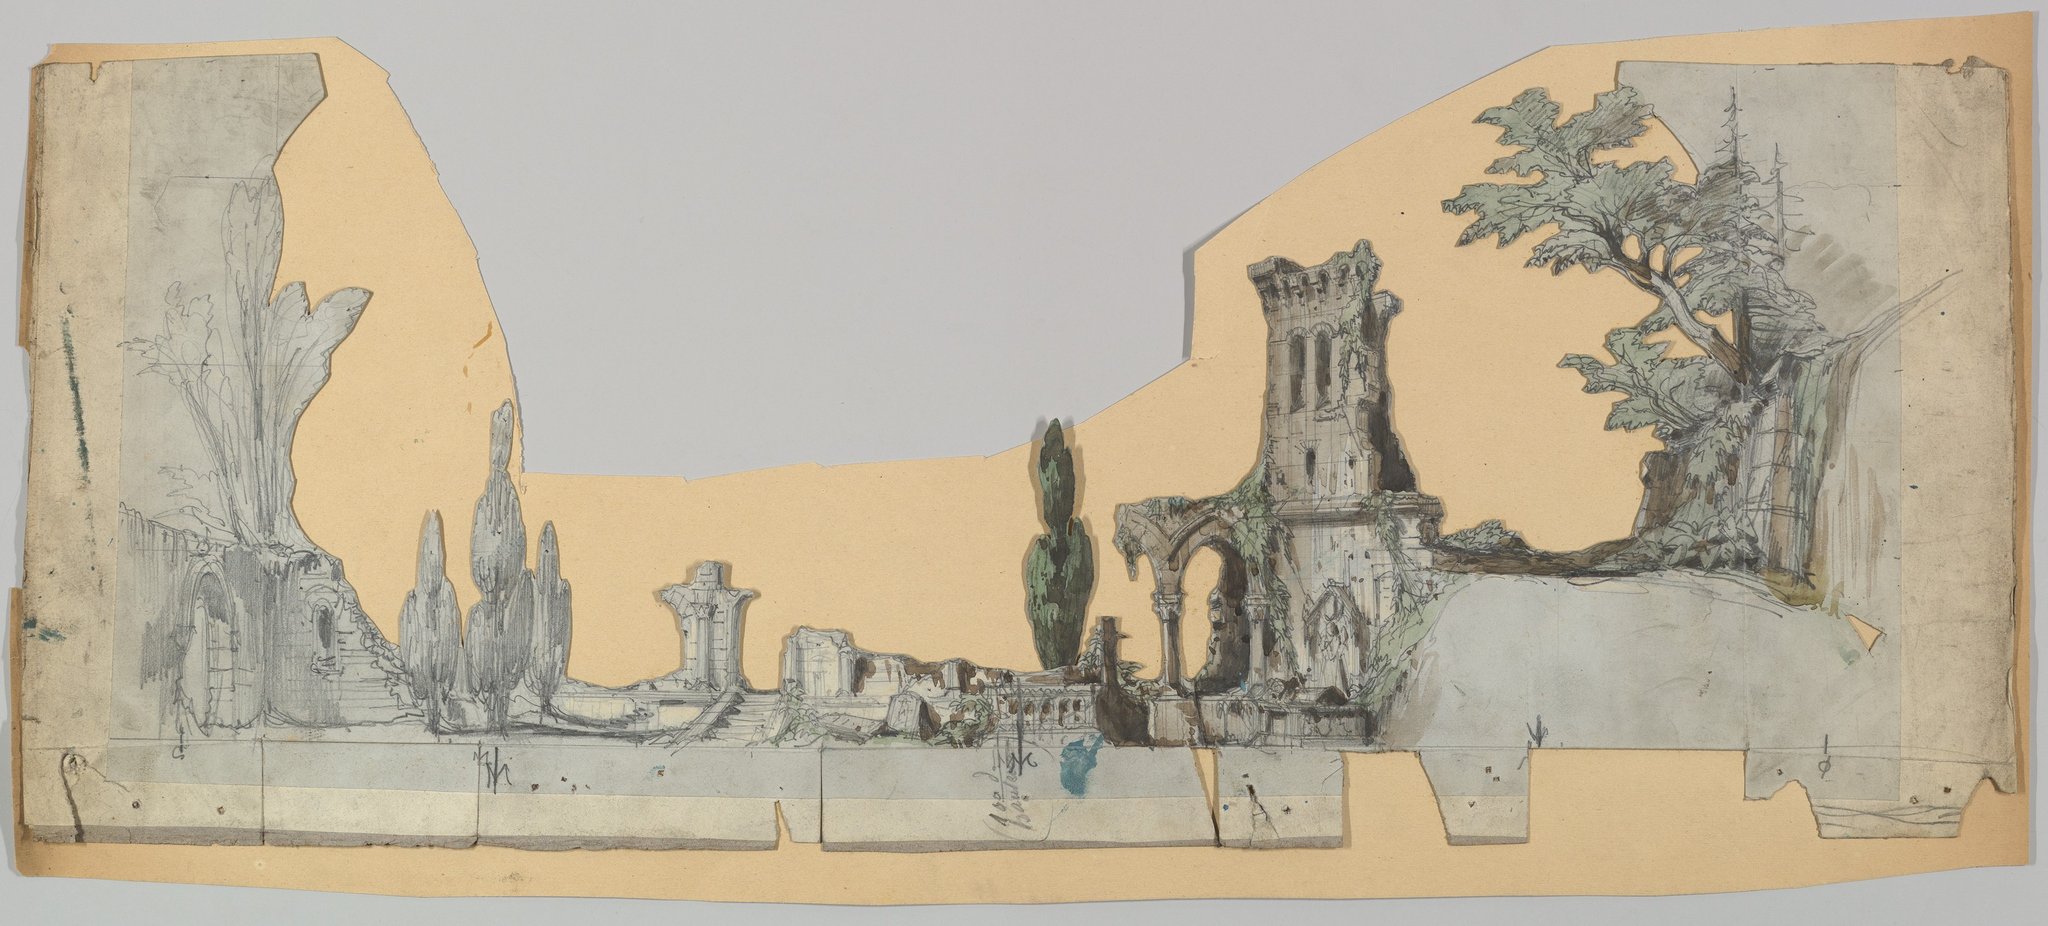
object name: drawing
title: Design for a Stage Set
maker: eugène cicéri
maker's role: artist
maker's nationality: french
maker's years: 1813-1890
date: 1830-1890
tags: stage design